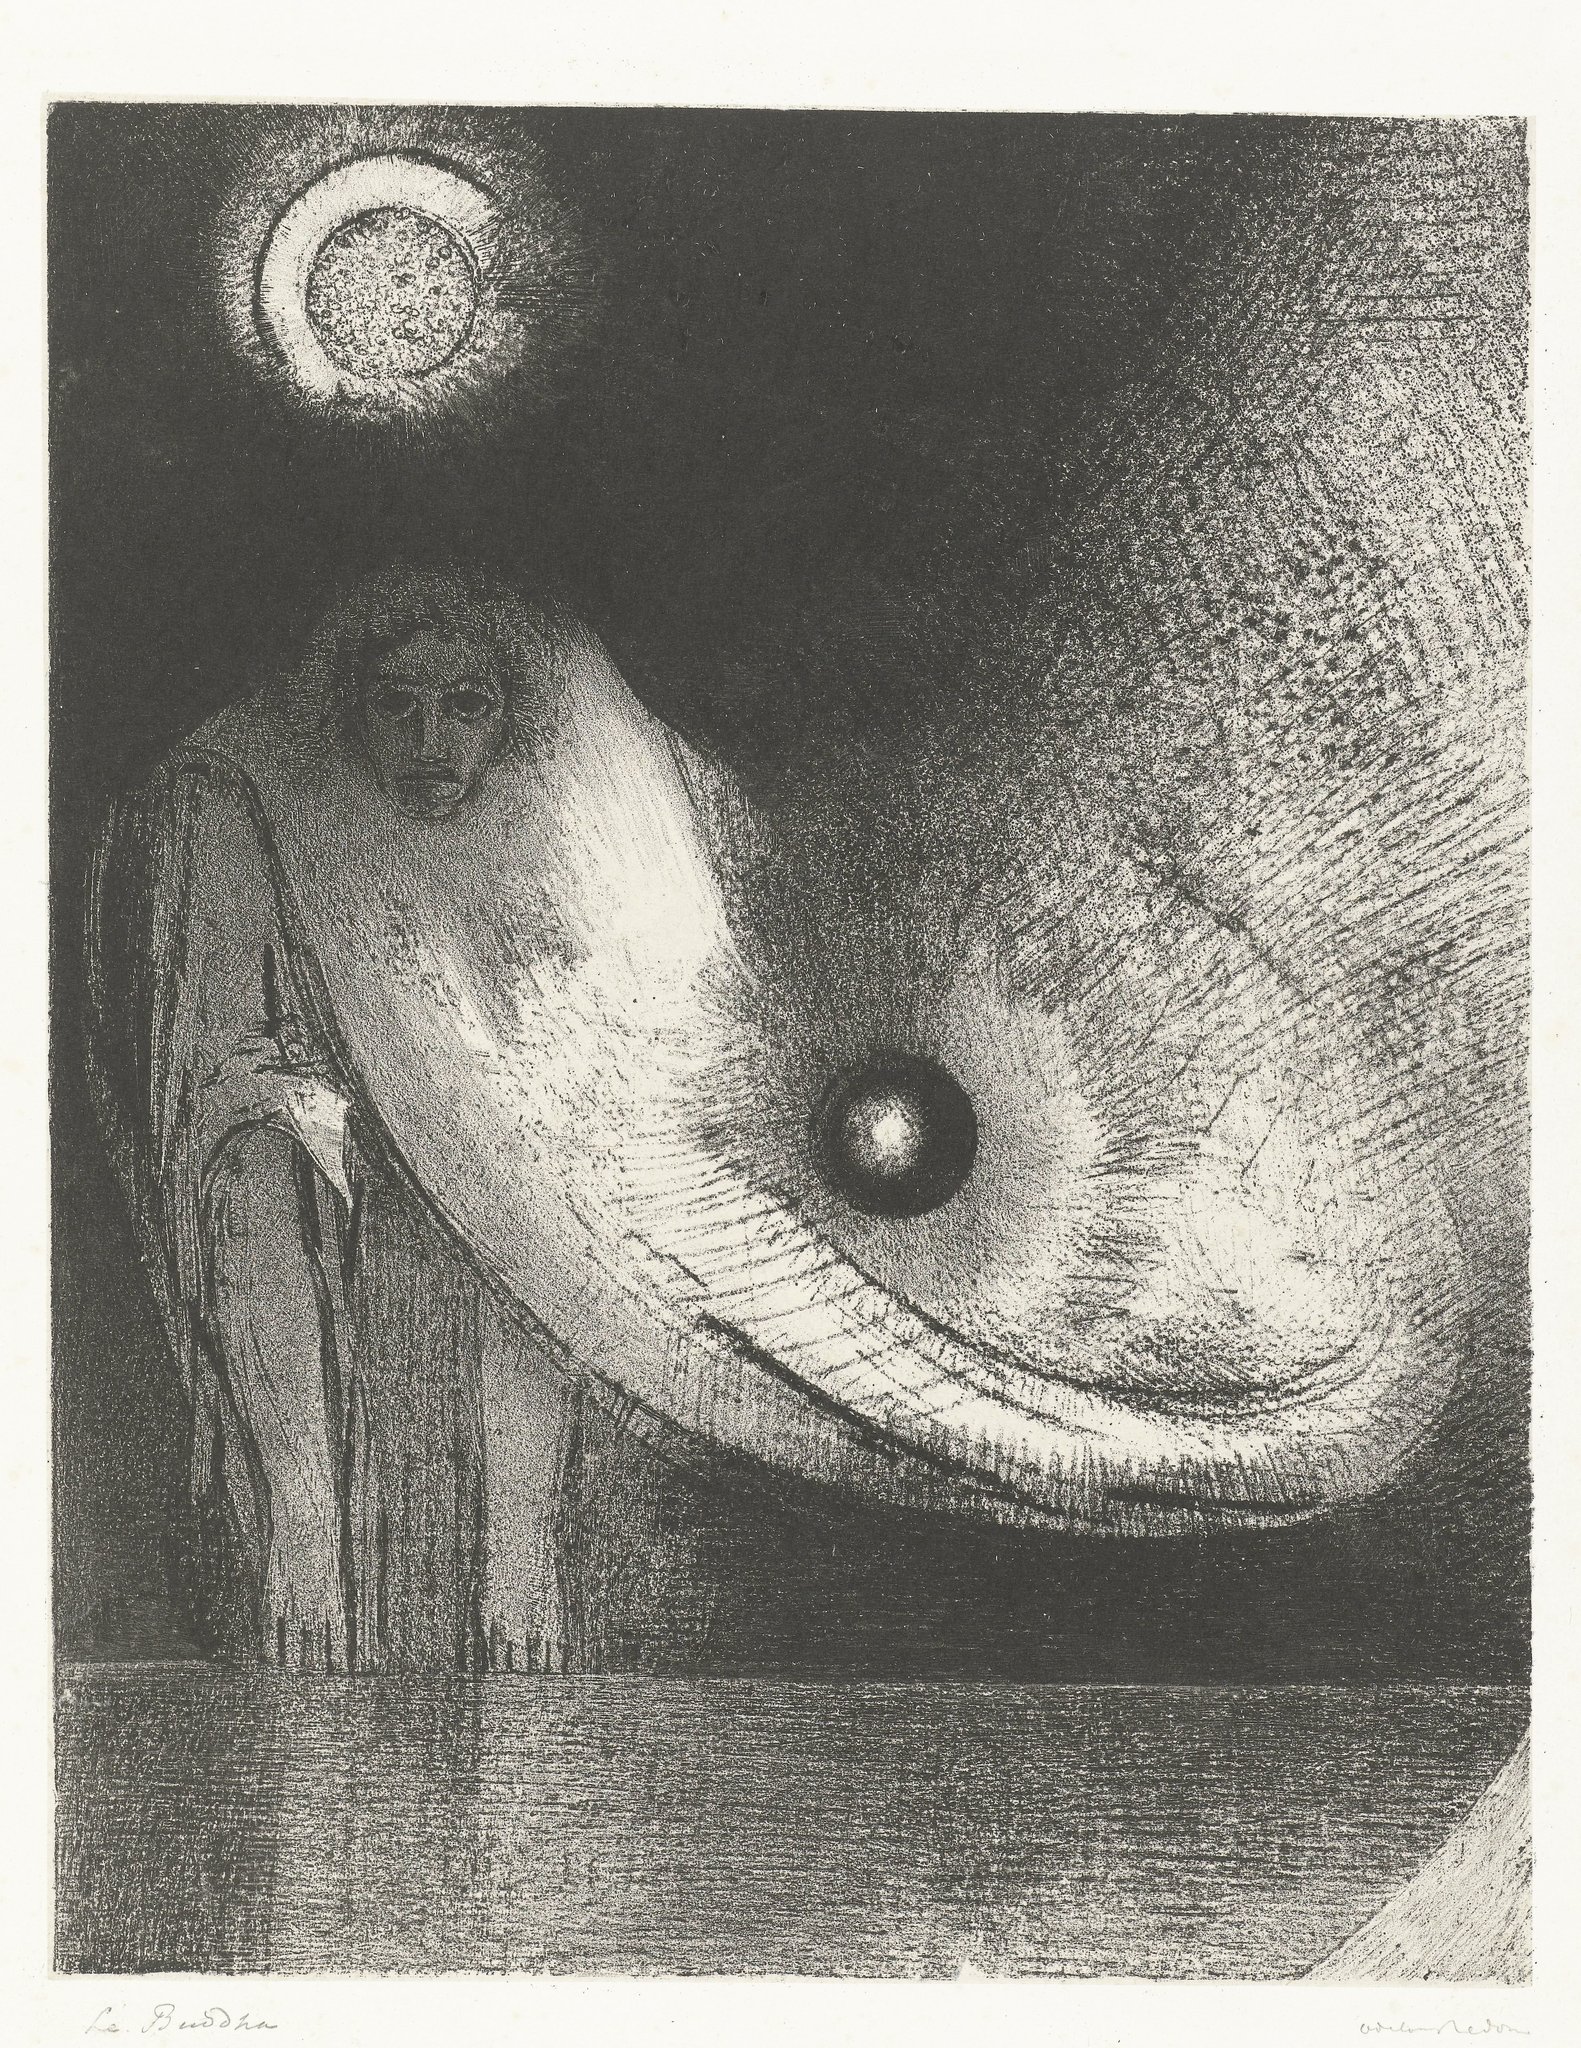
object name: print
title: L'Estampe originale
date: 1895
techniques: printmaking, lithograph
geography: paris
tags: buddha, founder of buddhism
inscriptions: collector's mark: Lugt 2228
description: Onderdeel van de portfolio "L'Estampe originale", uitgegeven door Editions du Journal des artistes (André Marty), in Parijs.